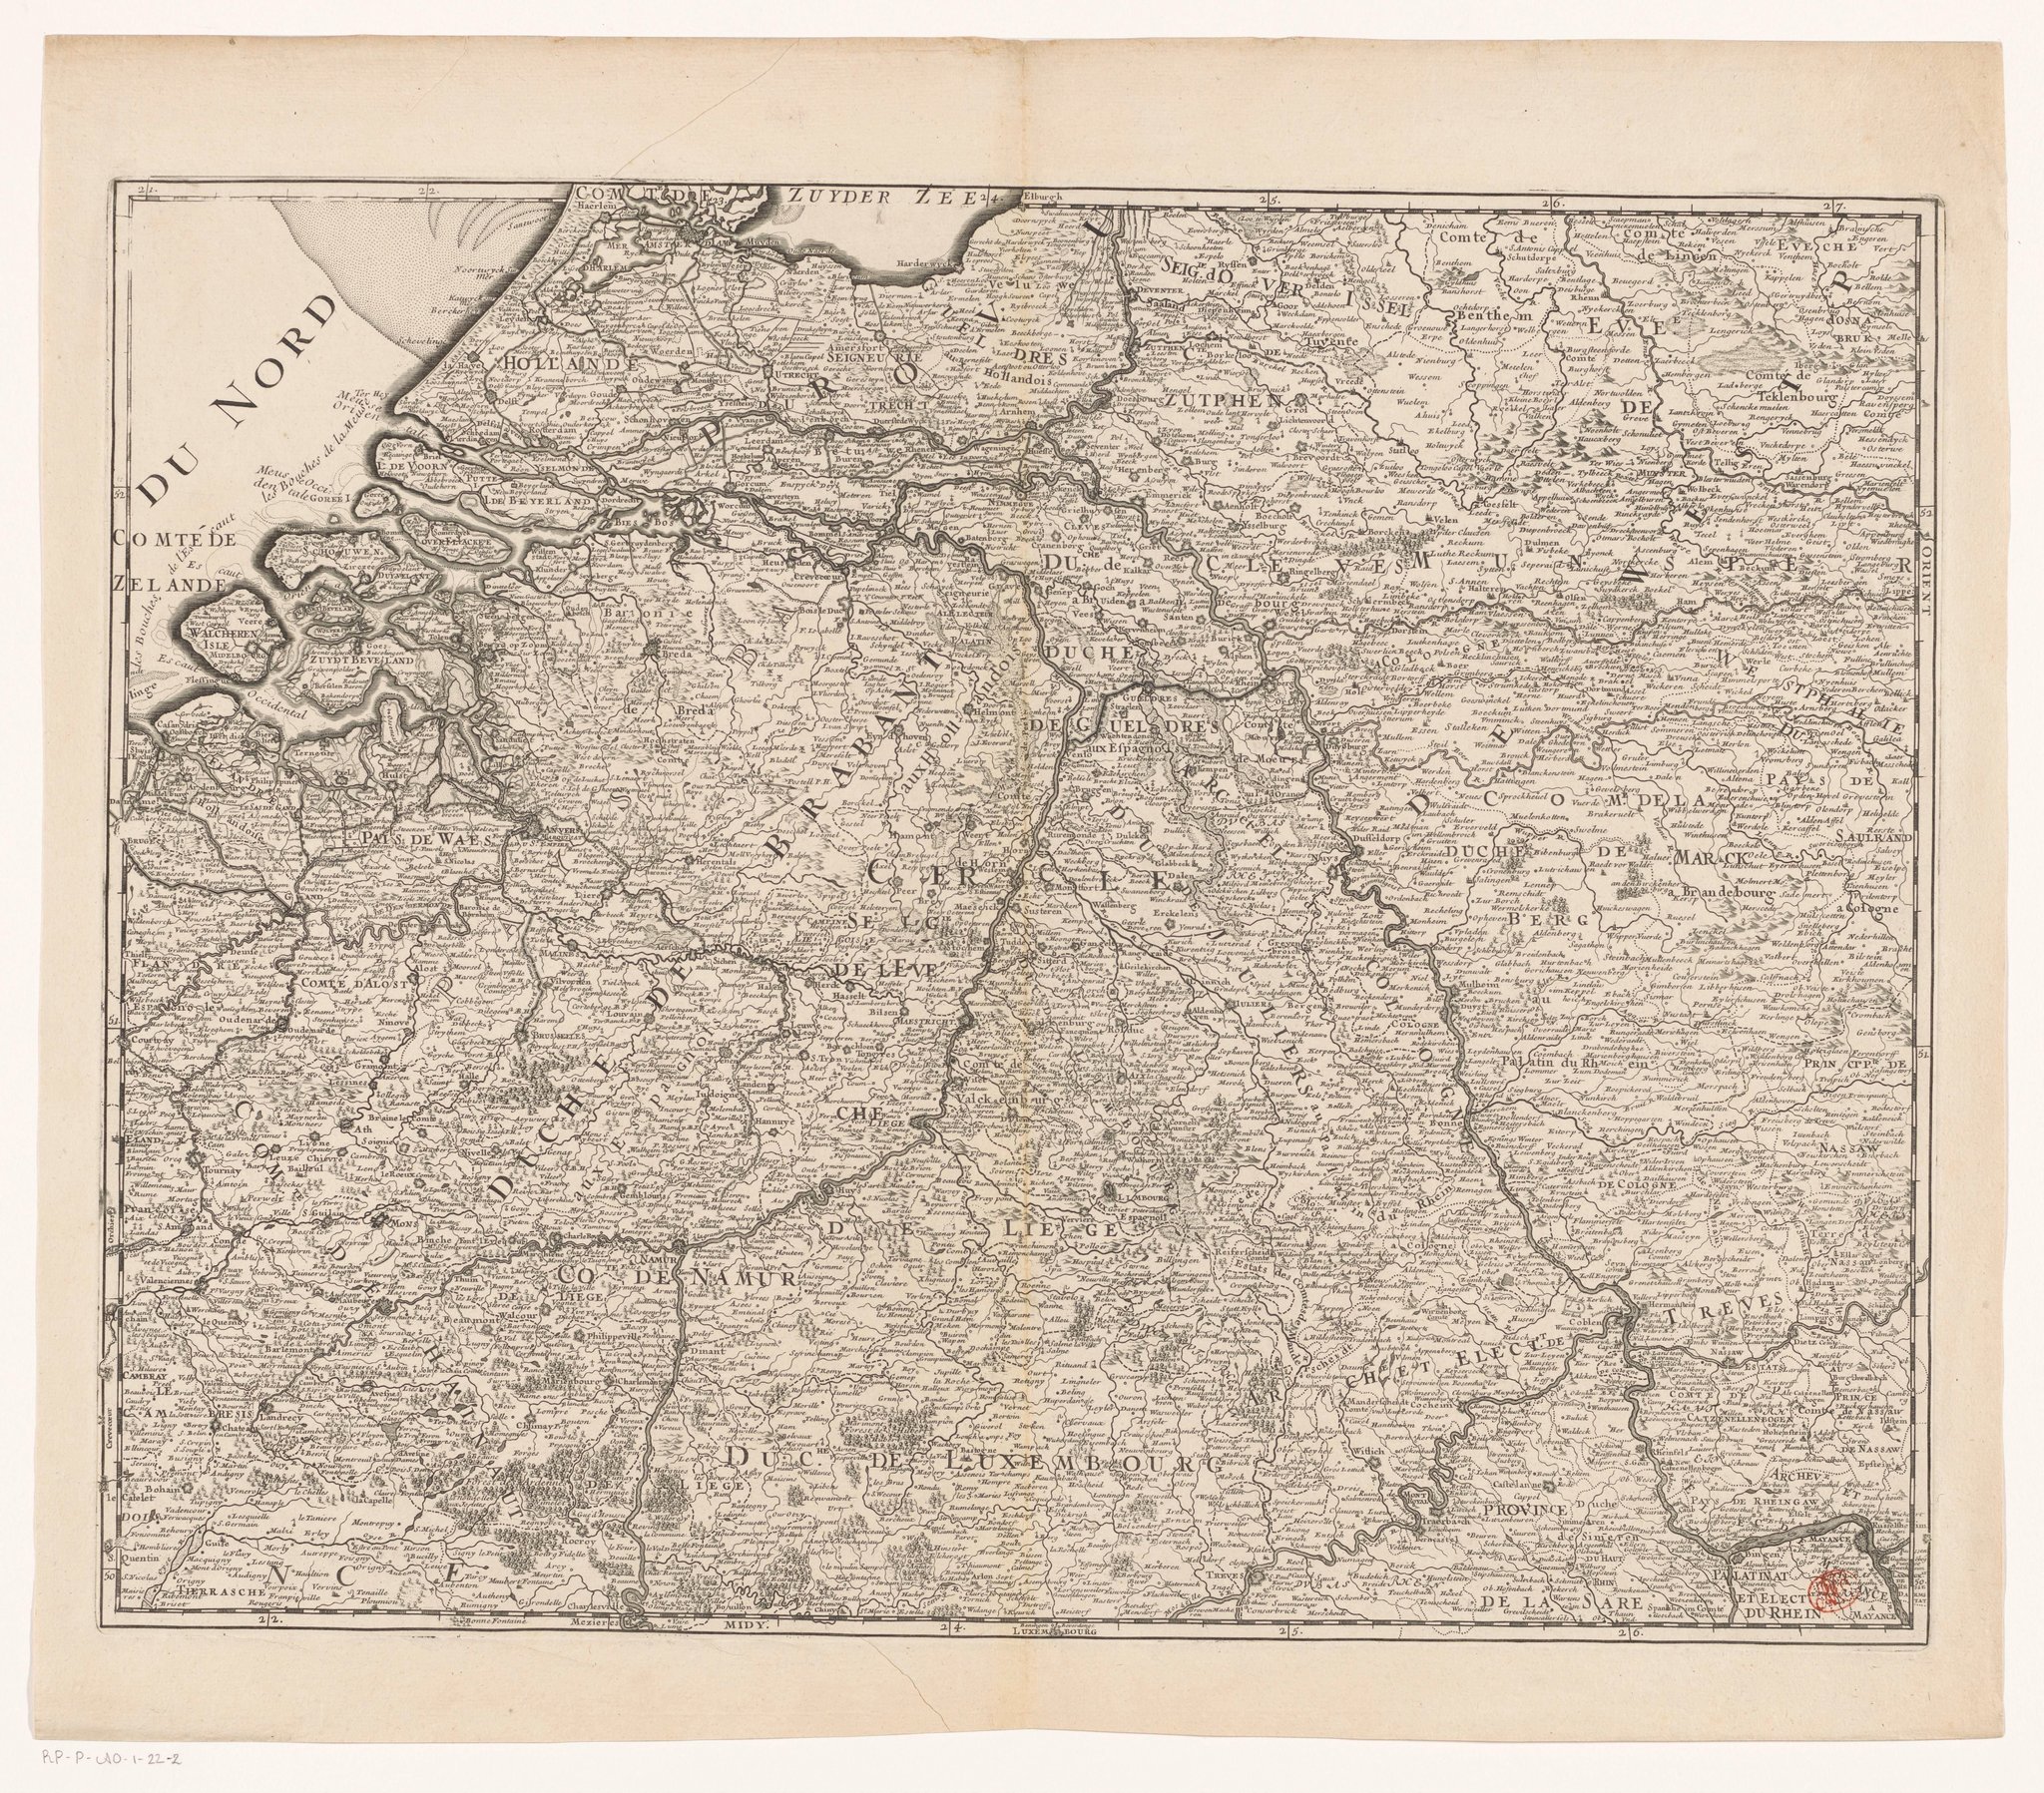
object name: print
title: Carte des XVII Provinces des Pays Bas ...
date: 1713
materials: paper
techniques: engraving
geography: paris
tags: maps of separate countries or regions, low countries, belgium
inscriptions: collector's mark: Lugt 195, collector's mark: Lugt 2228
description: Deel van een driedelige kaart van de Zeventien Provinciën met het zuidelijke gedeelte van Holland, Zeeland, Utrecht, Gelderland, Overijssel en een deel van de Zuidelijke Nederlanden. De kaart is voorzien van een gradenverdeling langs de randen.